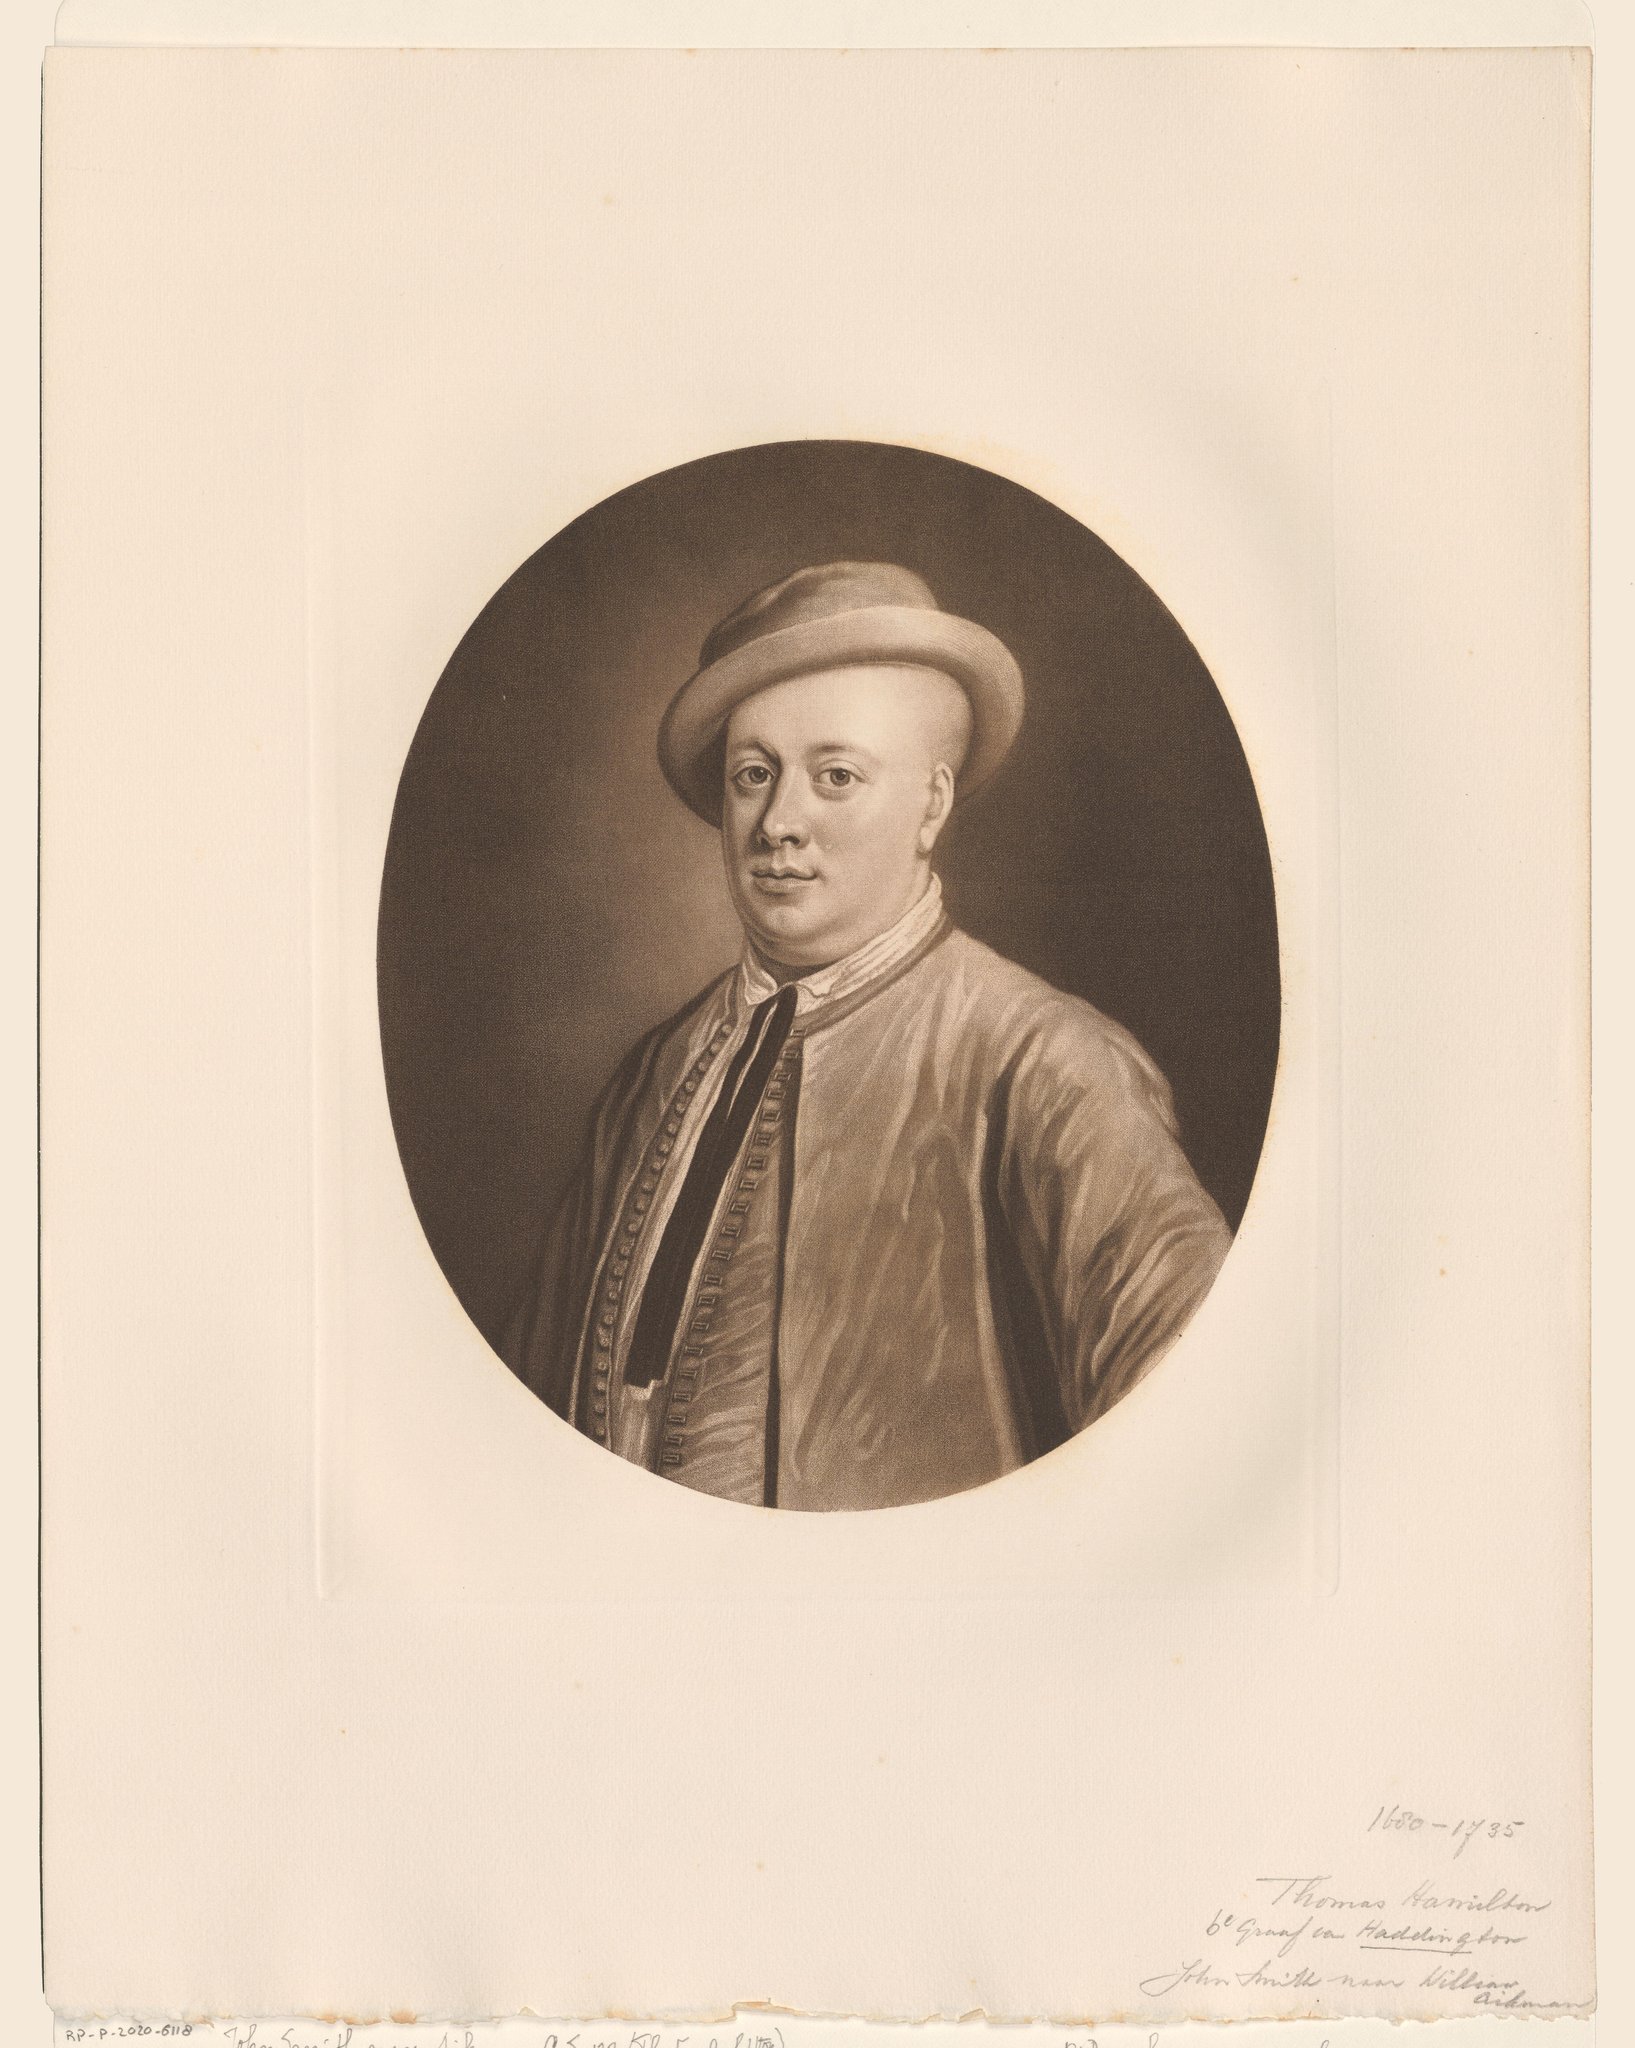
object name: photomechanical print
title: Portret van Thomas Hamilton, graaf van Haddington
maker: Anonymous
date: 1870-1915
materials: paper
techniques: photoaquatint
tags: politician, historical persons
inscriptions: collector's mark: Lugt 2228